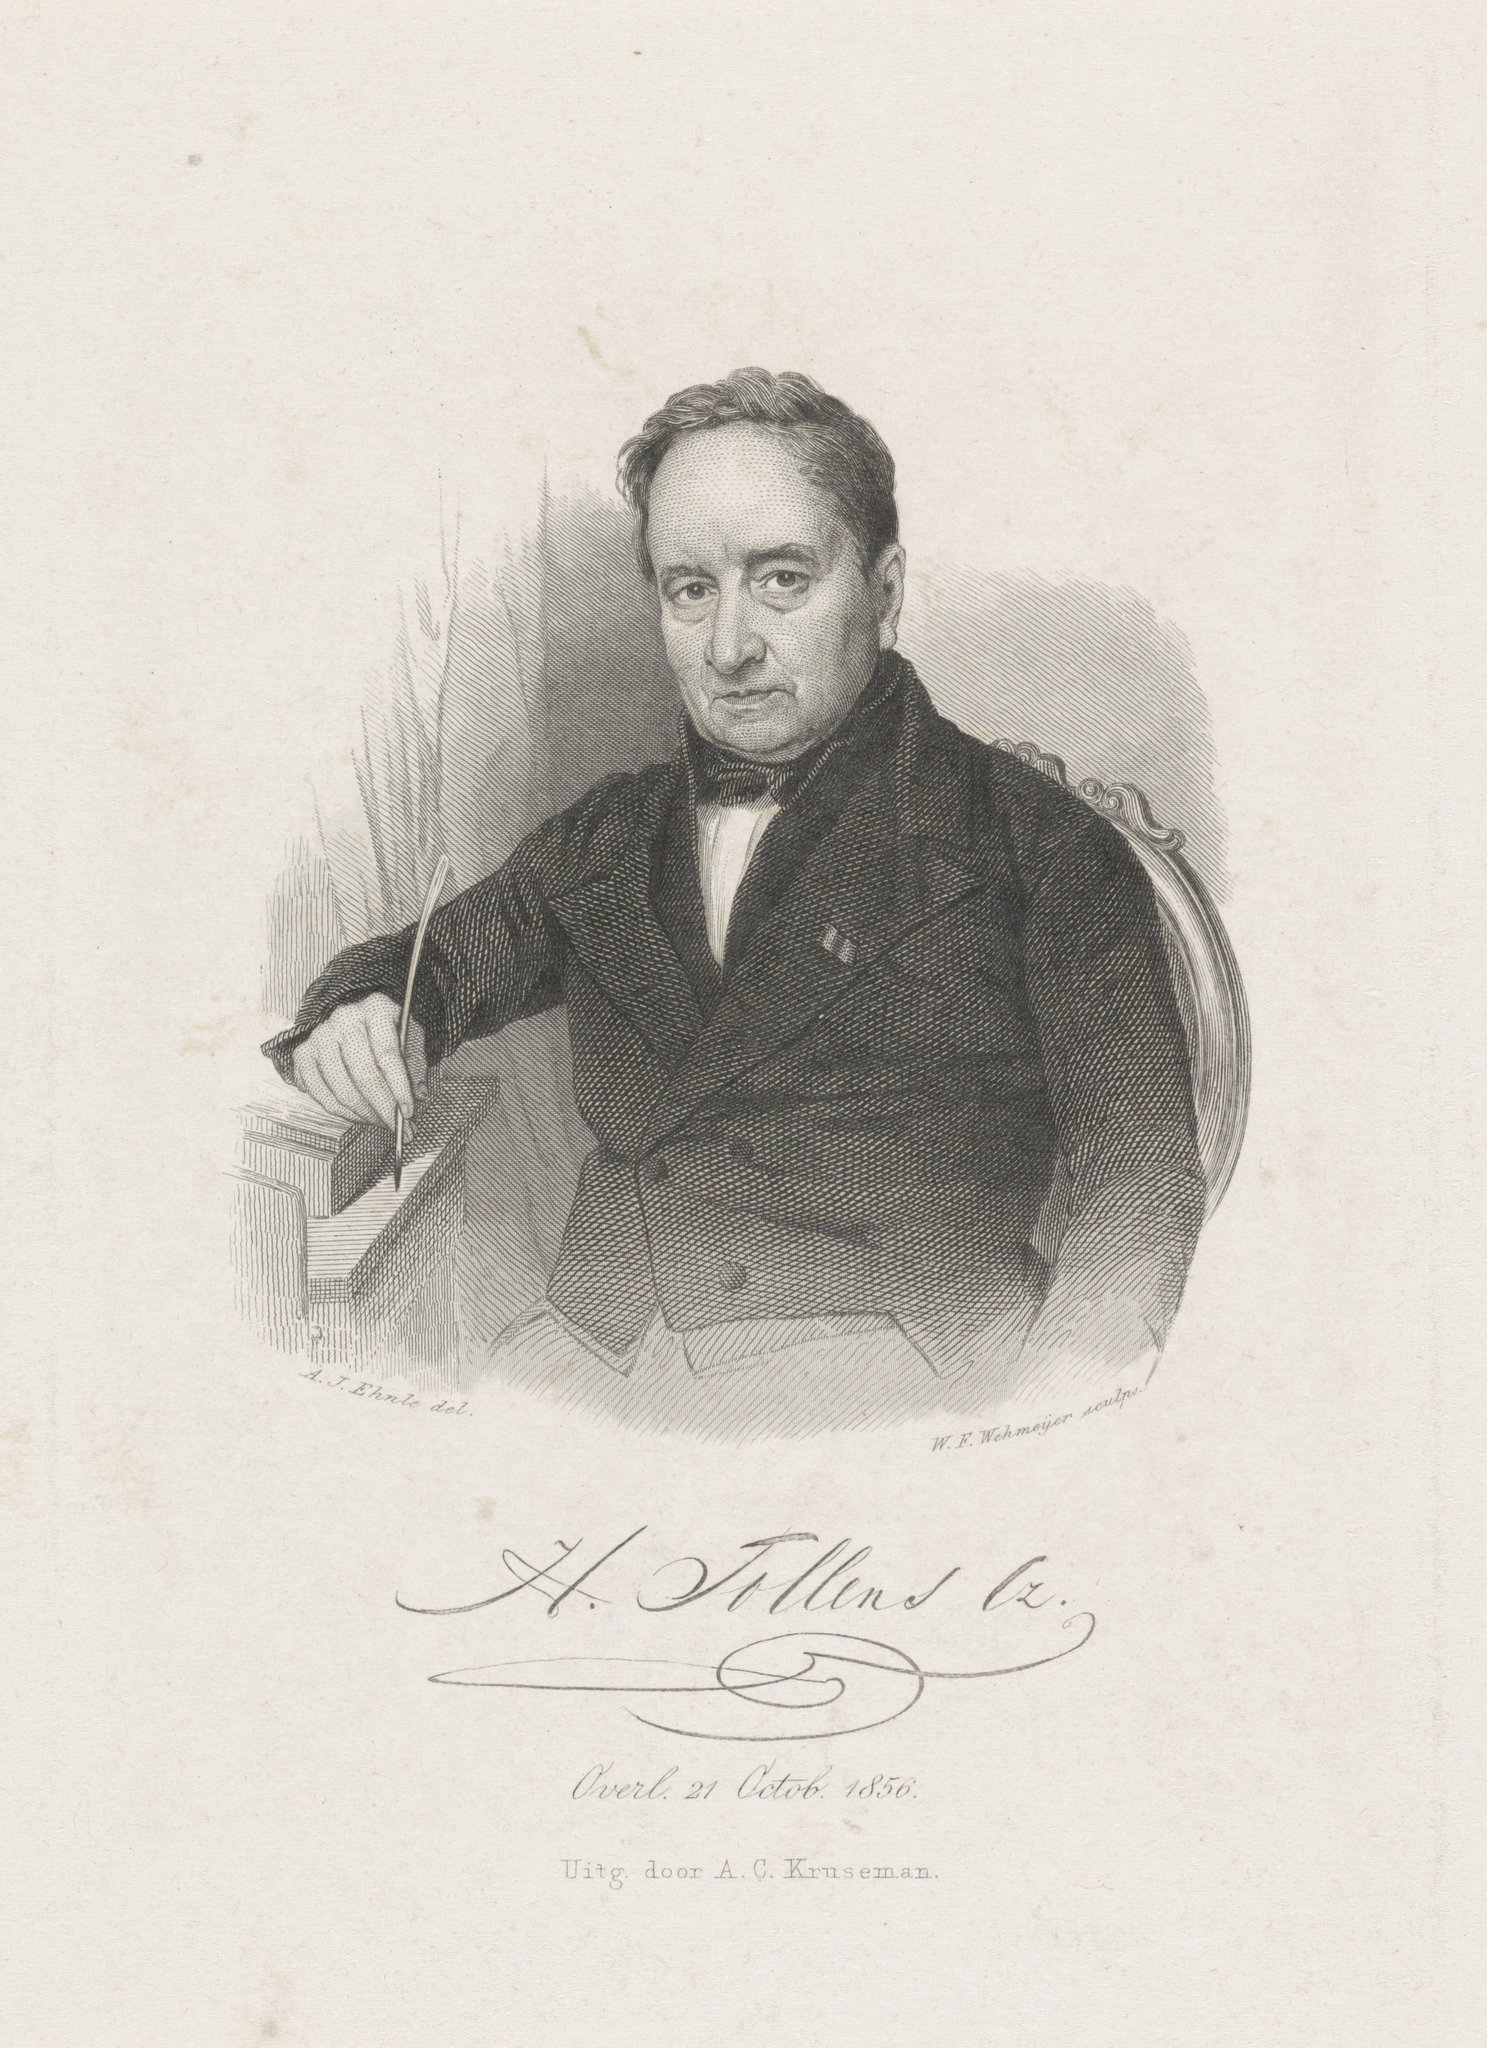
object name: print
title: Portret van Hendrik Tollens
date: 1834-1856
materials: paper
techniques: engraving, etching, roulette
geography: haarlem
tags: hendrik tollens, adult man, historical persons, chair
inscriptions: collector's mark: Lugt 2228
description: Portret van Hendrik Tollens, dichter. Hij zit op een stoel voor een gordijn en houdt schrijfgerei in zijn rechterhand. Zijn rechterarm rust op een opengeslagen boek. Onder de voorstelling bevindt zich de signatuur en de sterfdatum van de geportretteerde.